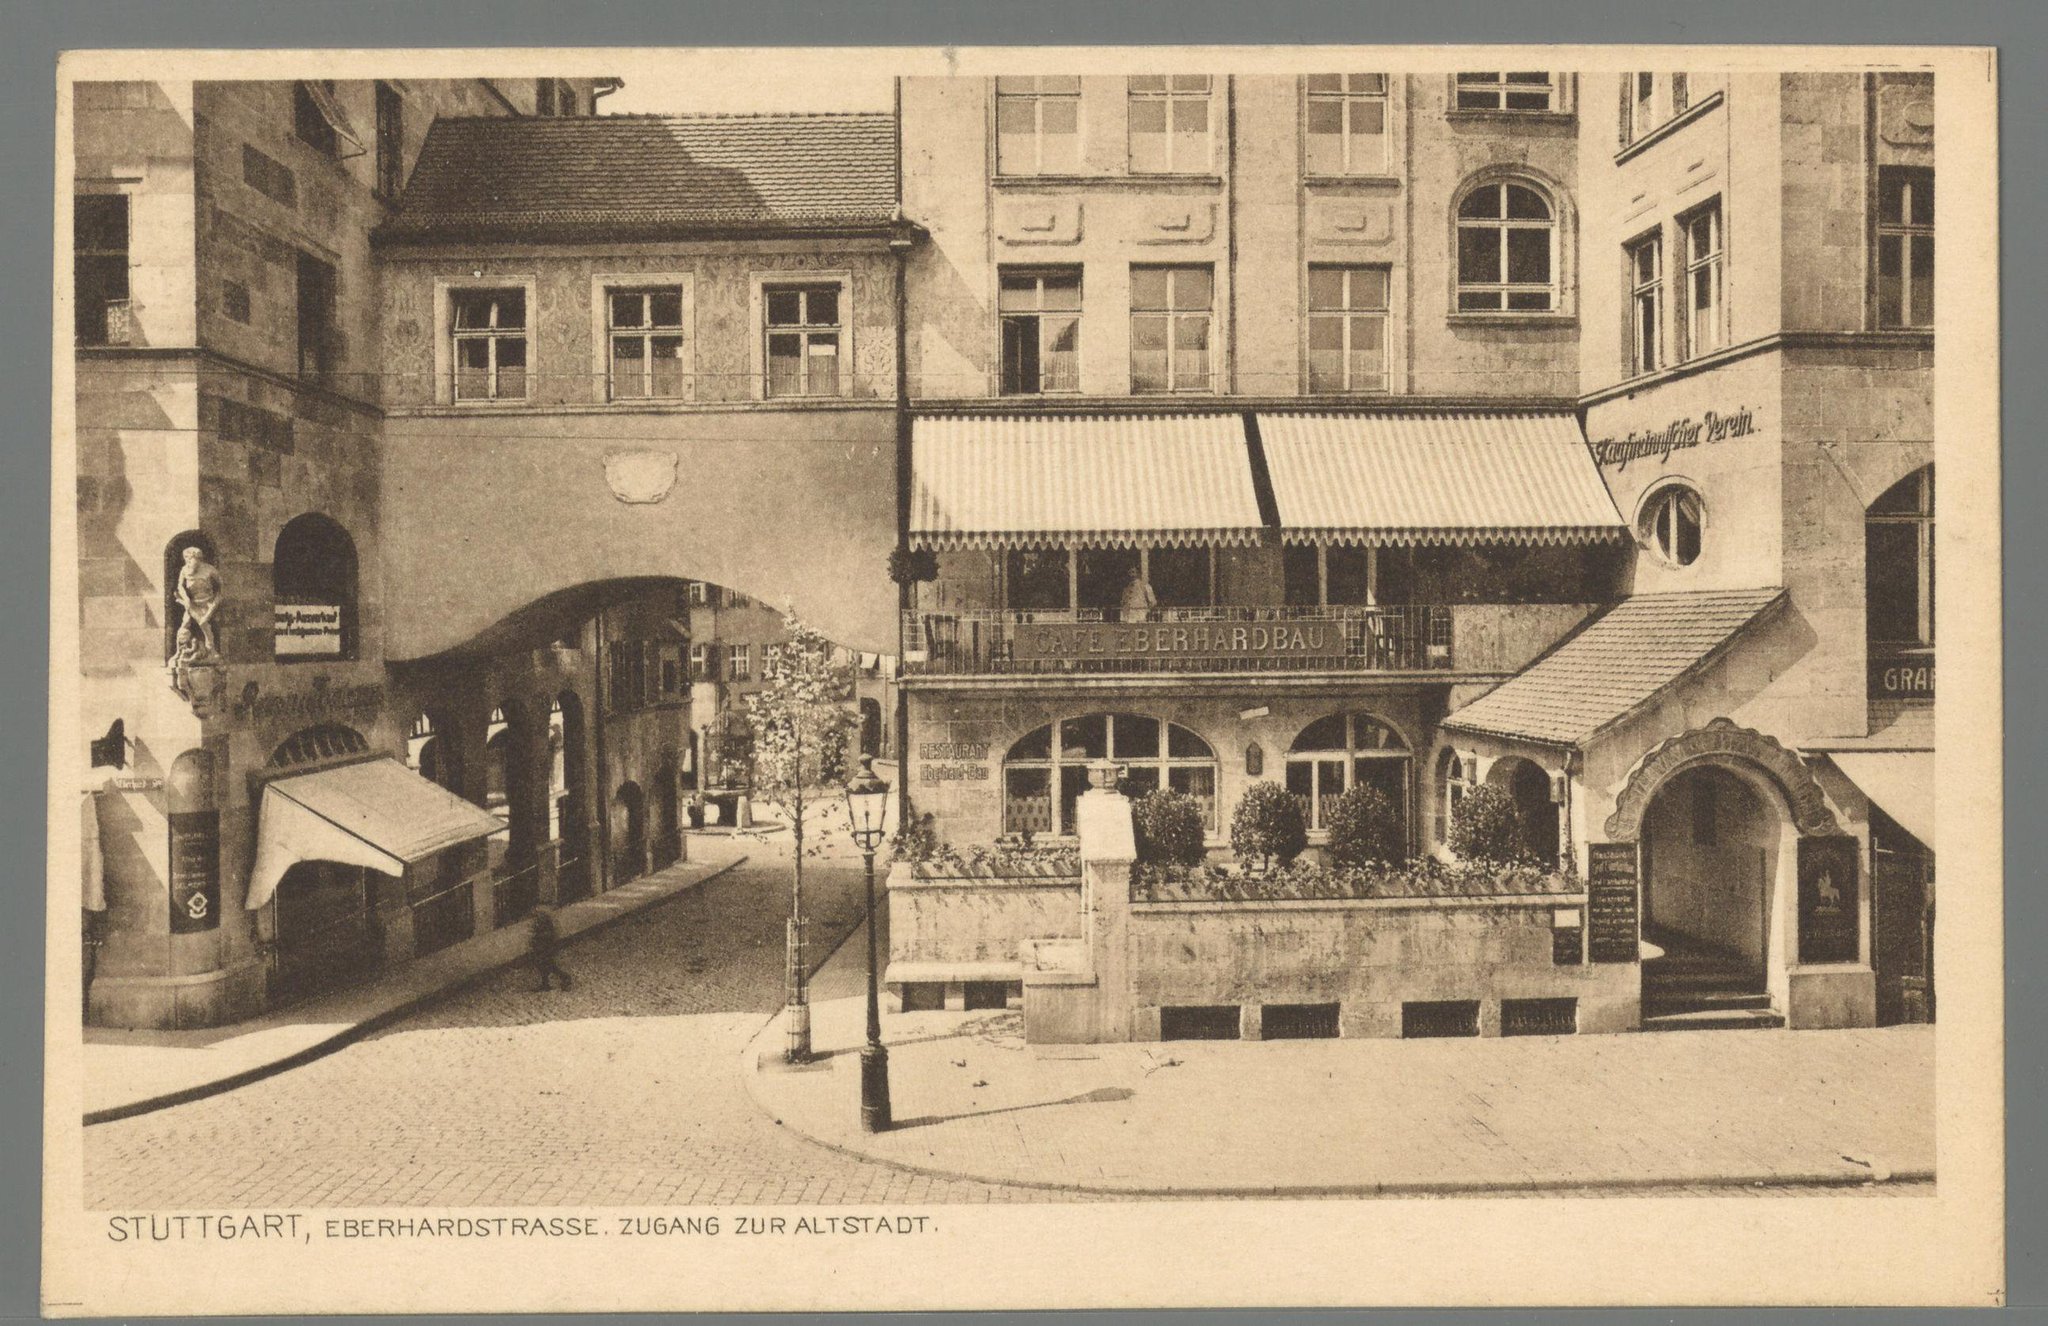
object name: ansichtkaart, prentbriefkaart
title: Stuttgart, Eberhardstrasse. Zugang zur Altstadt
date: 1905-1909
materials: cardboard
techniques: photoaquatint, writing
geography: stuttgart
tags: restaurant, street, city-gate